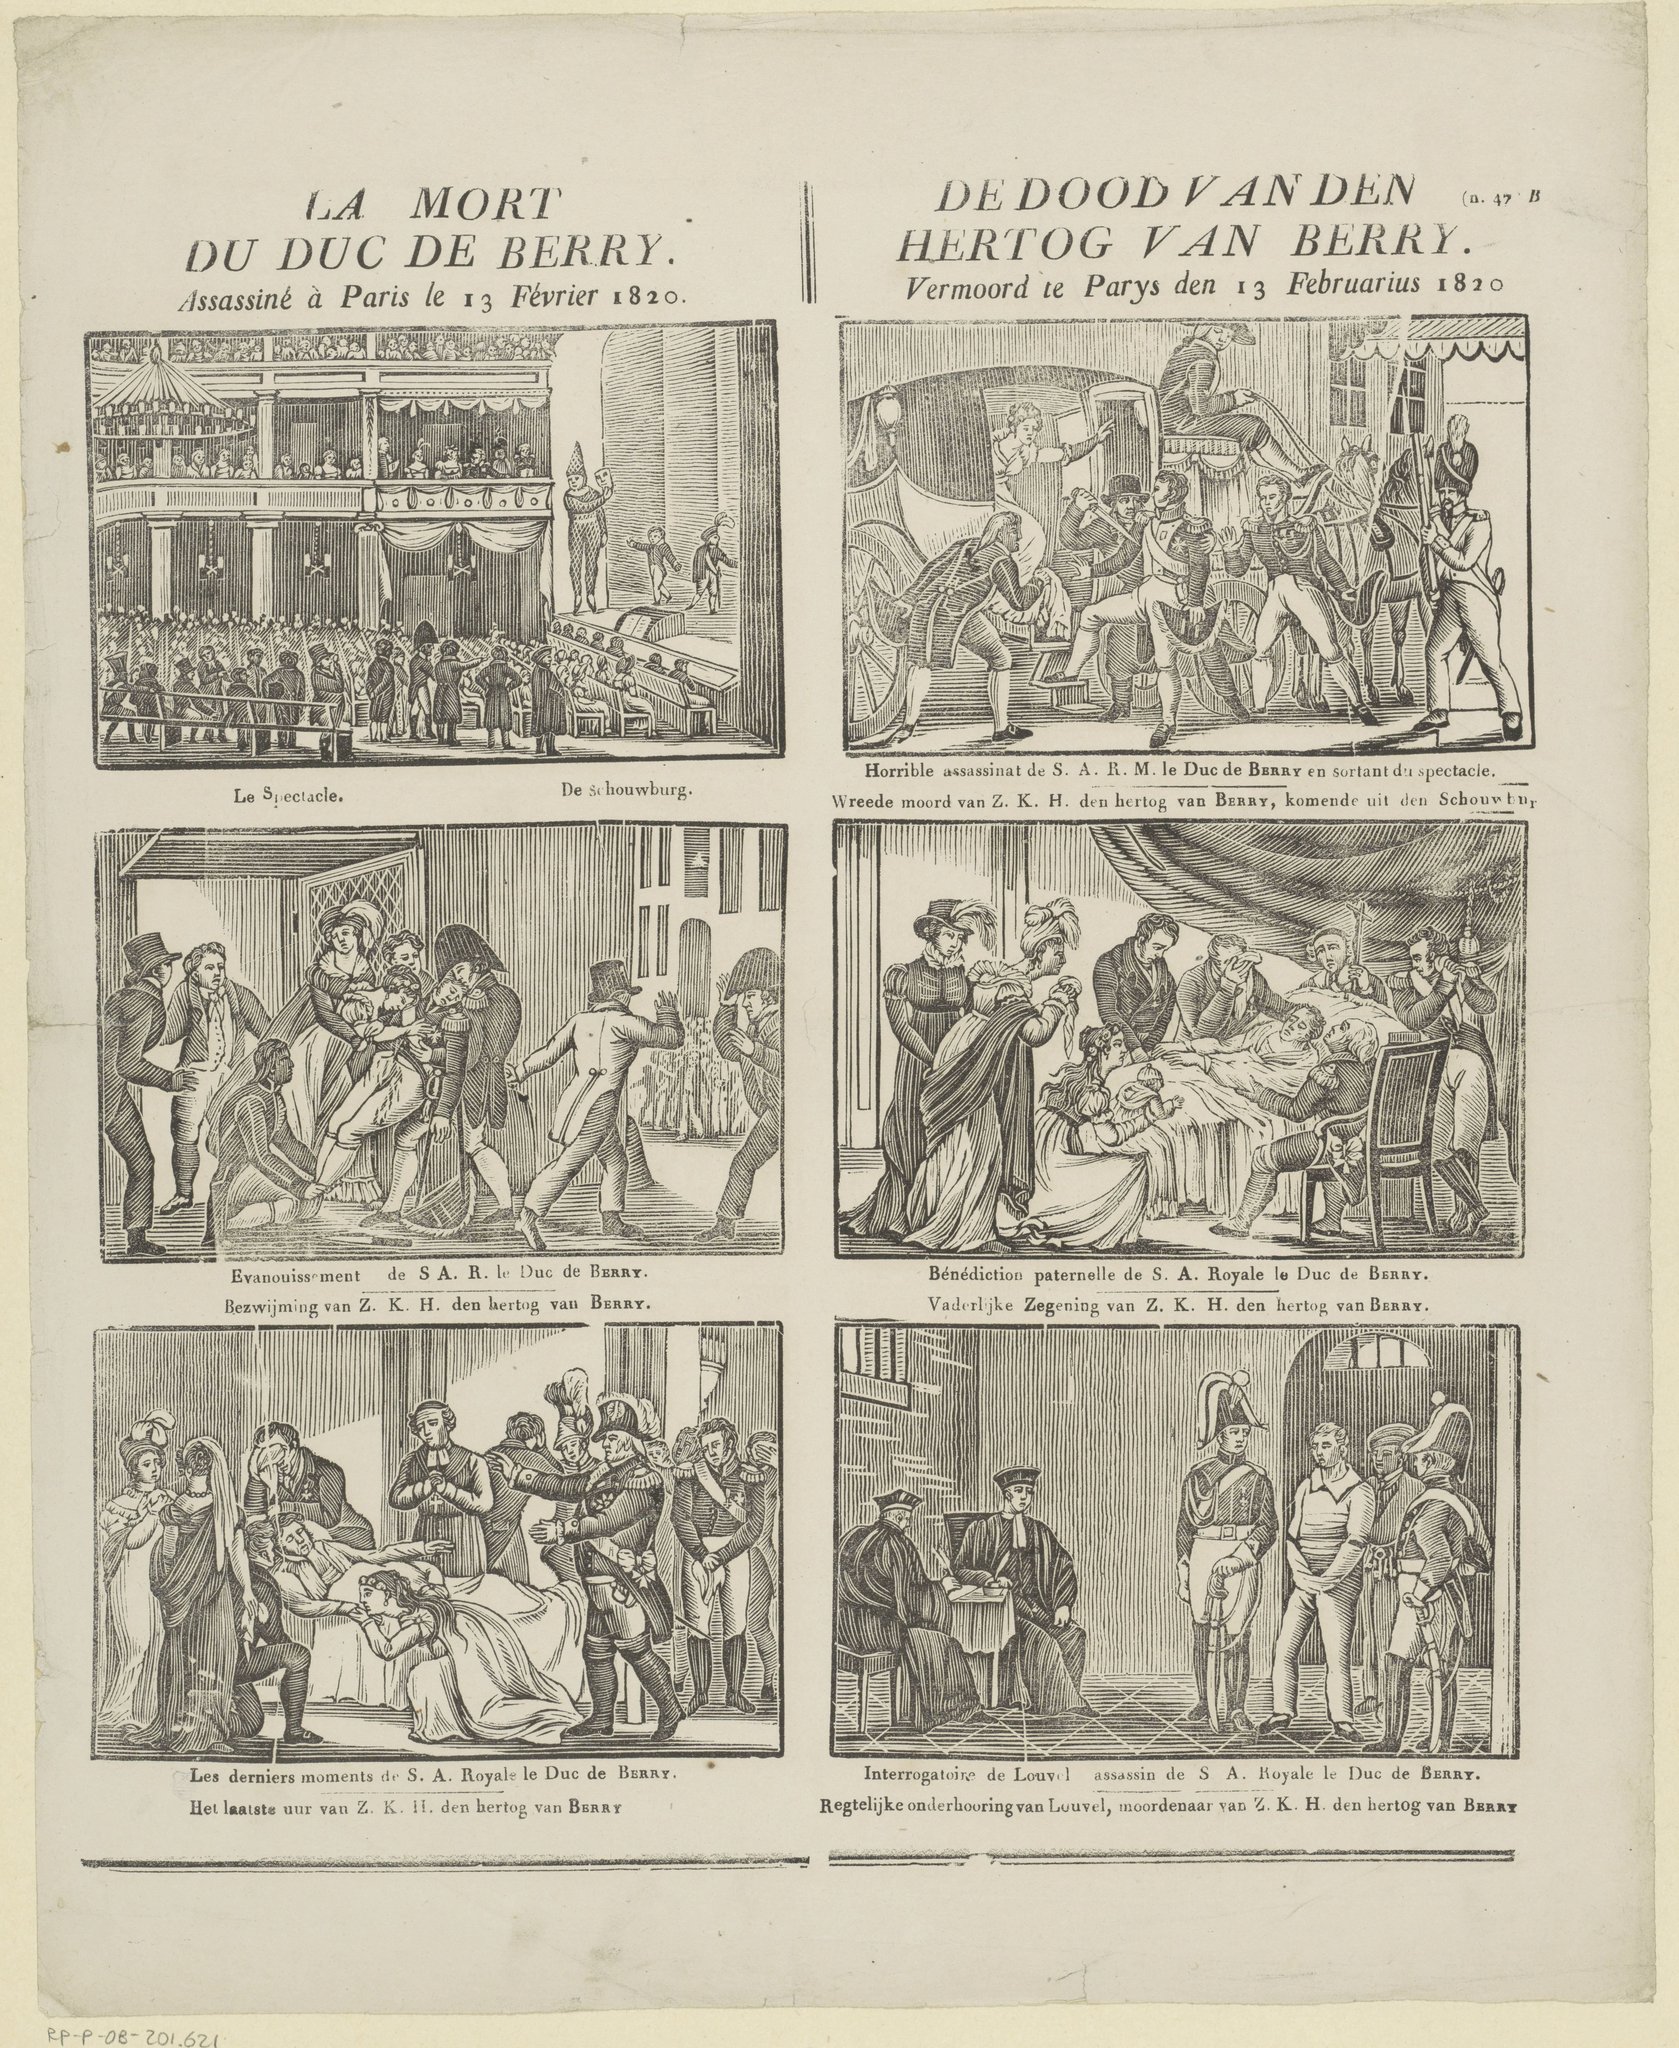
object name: print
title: La mort du / Duc de Berry. / Assassiné à Paris le 13 Février 1820 / Dood van den / Hertog van de Berry. / Vermoord te Parijs den 13 Februari 1820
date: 1800-1833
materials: paper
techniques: letterpress printing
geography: turnhout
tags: paris, extreme unction ~ the last of the seven sacraments, theatre (building), murder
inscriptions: collector's mark: Lugt 2760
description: Blad met 6 voorstellingen over de moord op Karel Ferdinand van Berry op 13 februari 1820 te Parijs. Onder elke voorstelling een onderschrift in het Nederlands en in het Frans. Genummerd rechtsboven: n. 47 B.